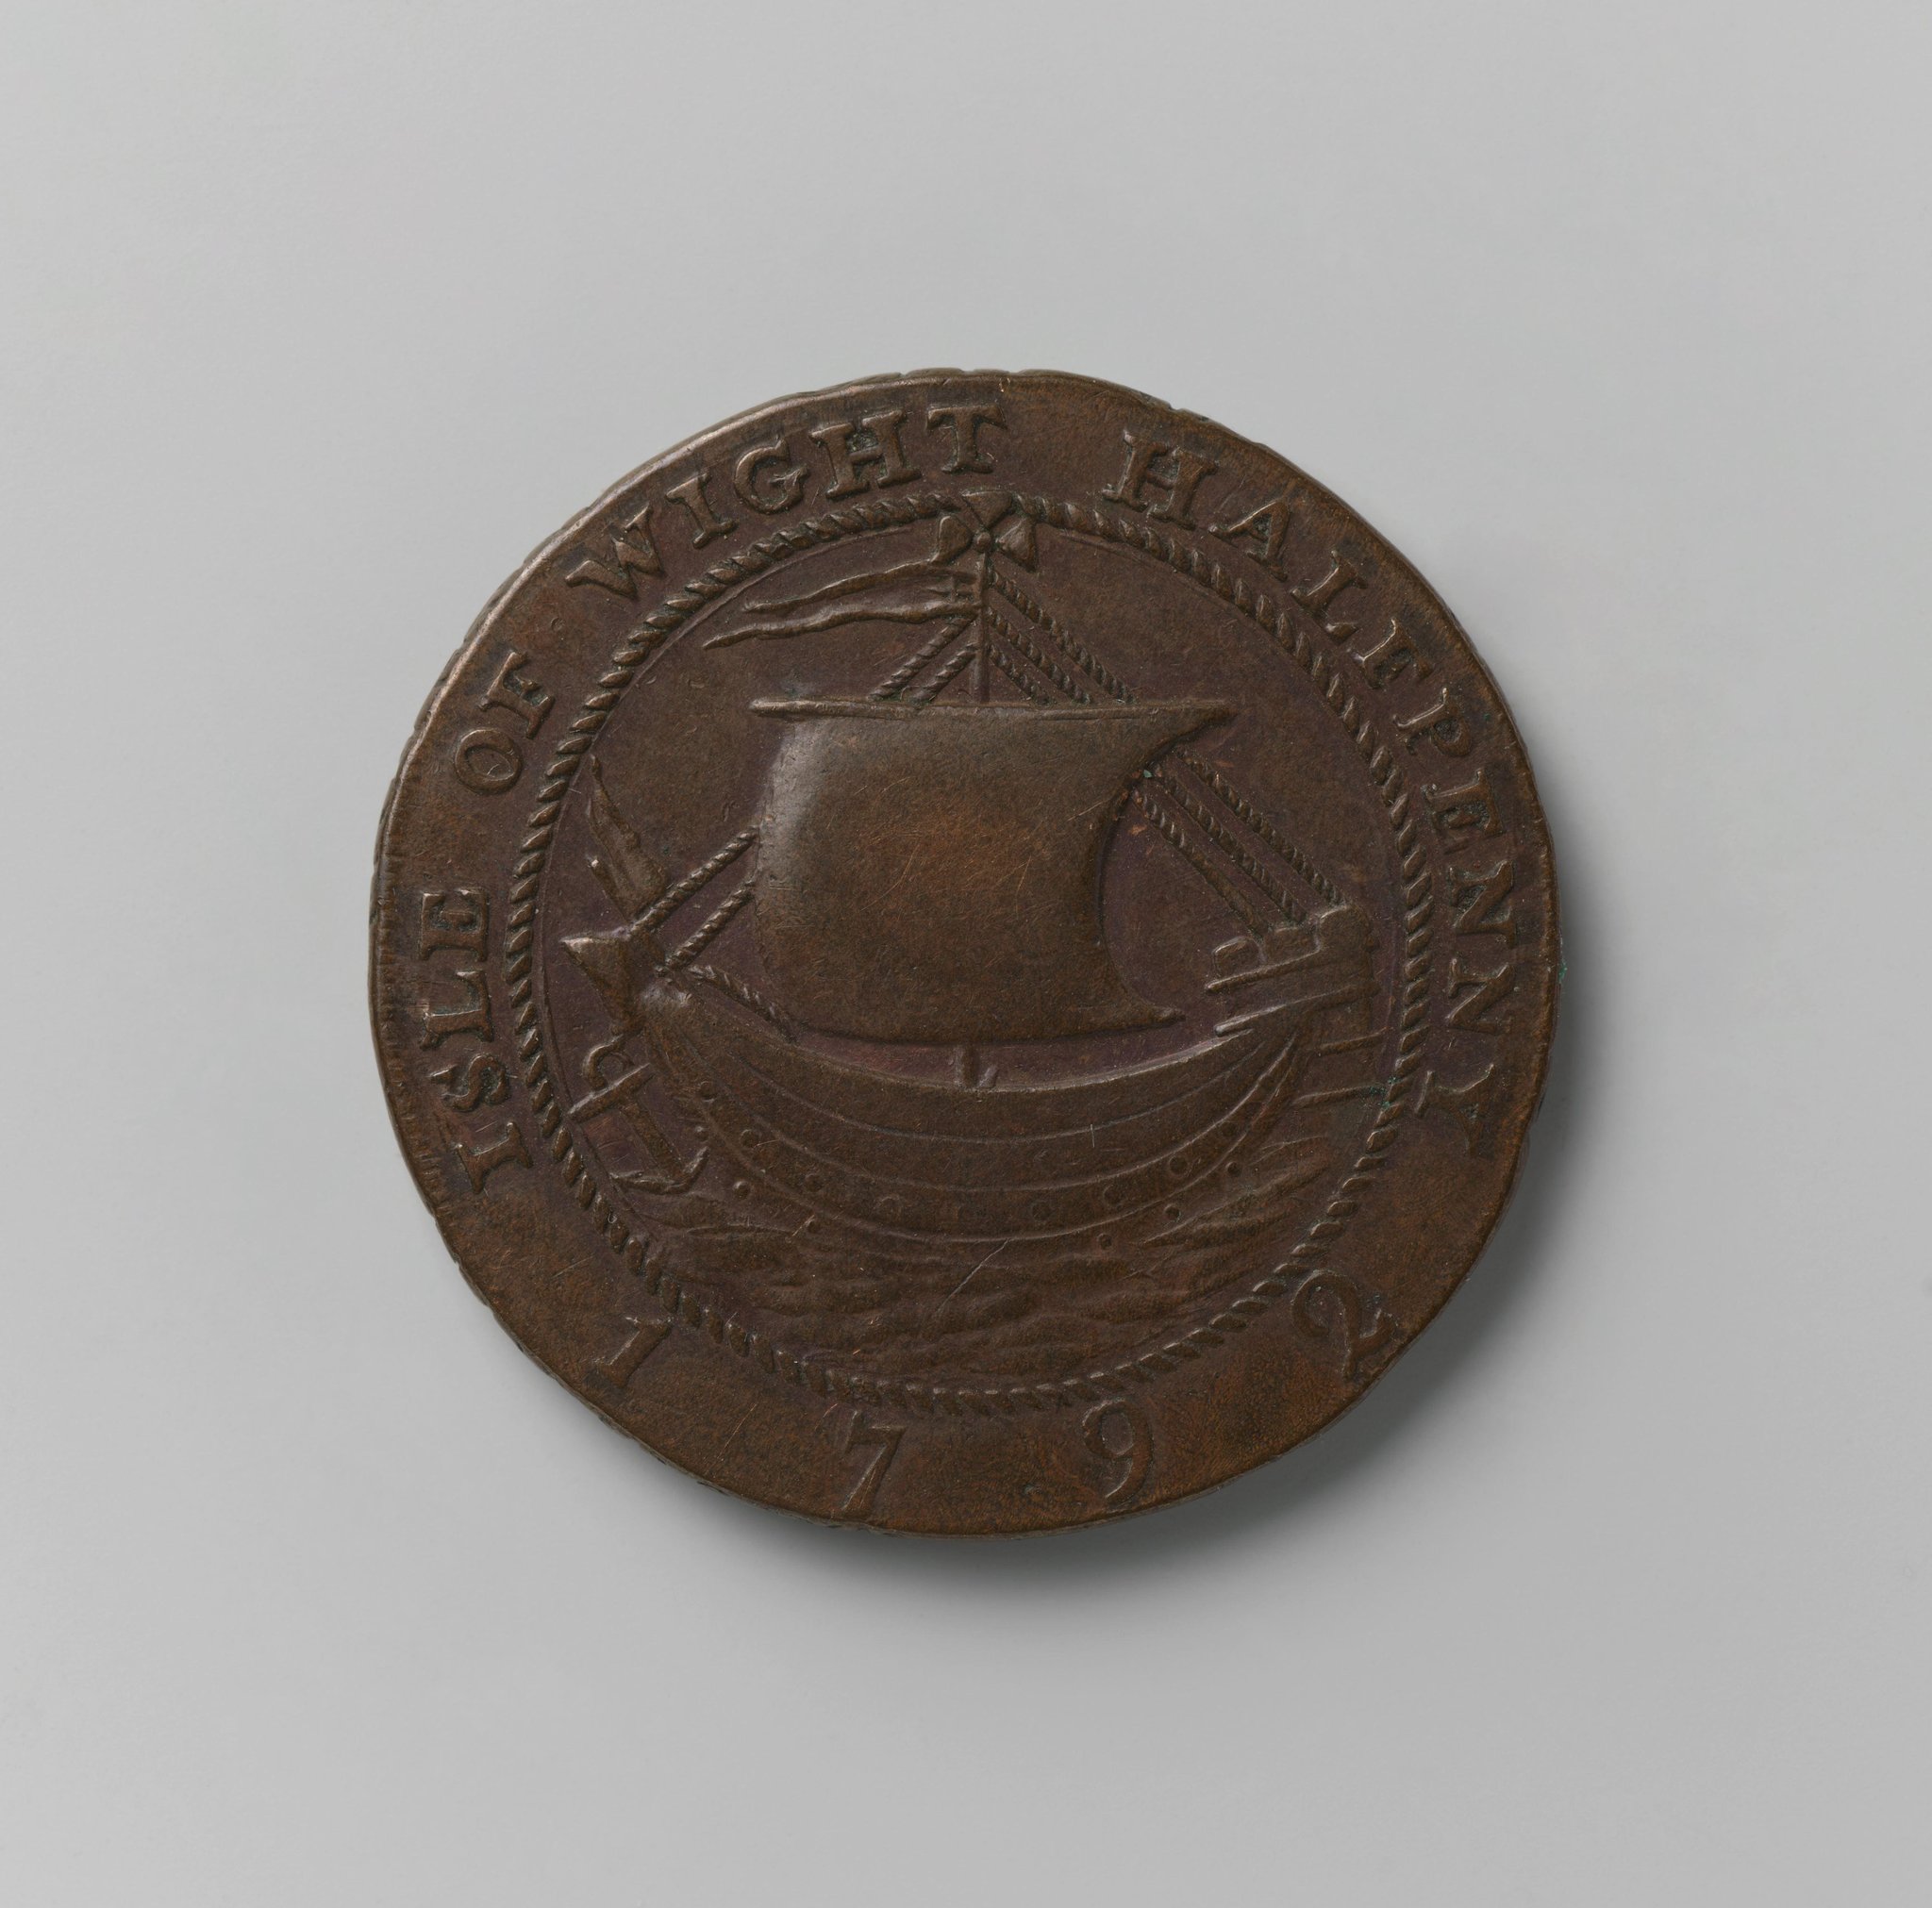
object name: halve penny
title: betaalpenning (token) voor een halve penny uit het eiland Wight, Engeland, 1792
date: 1792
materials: copper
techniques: striking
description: Koperen particuliere munt. Voorzijde: koggeschip varend op zee. Waarde-aanduiding en jaartal in omschrift. Keerzijde: borstbeeld van een man naar links. Randschrift.